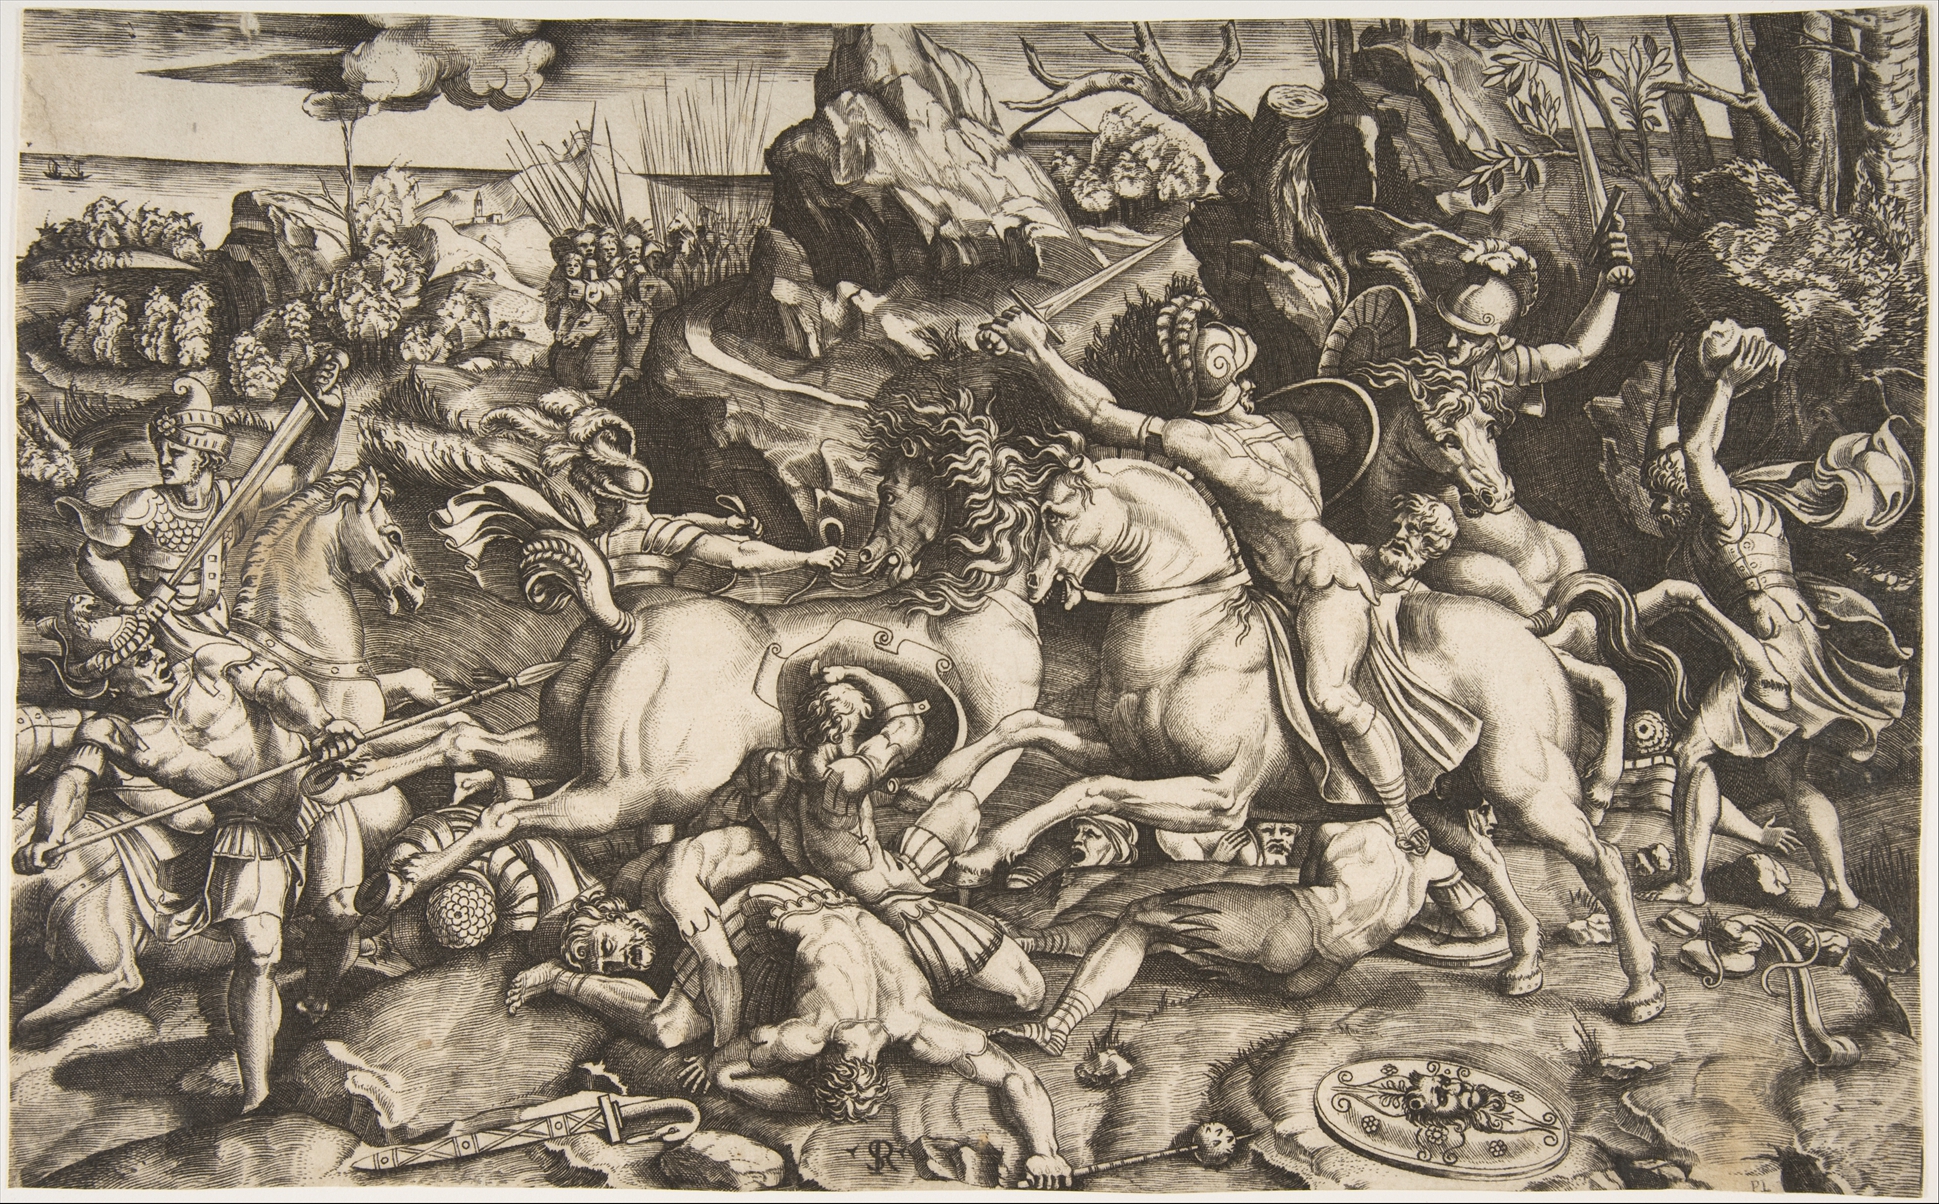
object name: print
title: Battle scene in a landscape with soldiers on horseback and several fallen men, another group of riders in the background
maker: marco dente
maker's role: artist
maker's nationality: italian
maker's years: 1515-1527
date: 1520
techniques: engraving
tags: battles,soldiers,weapons,horses,landscapes